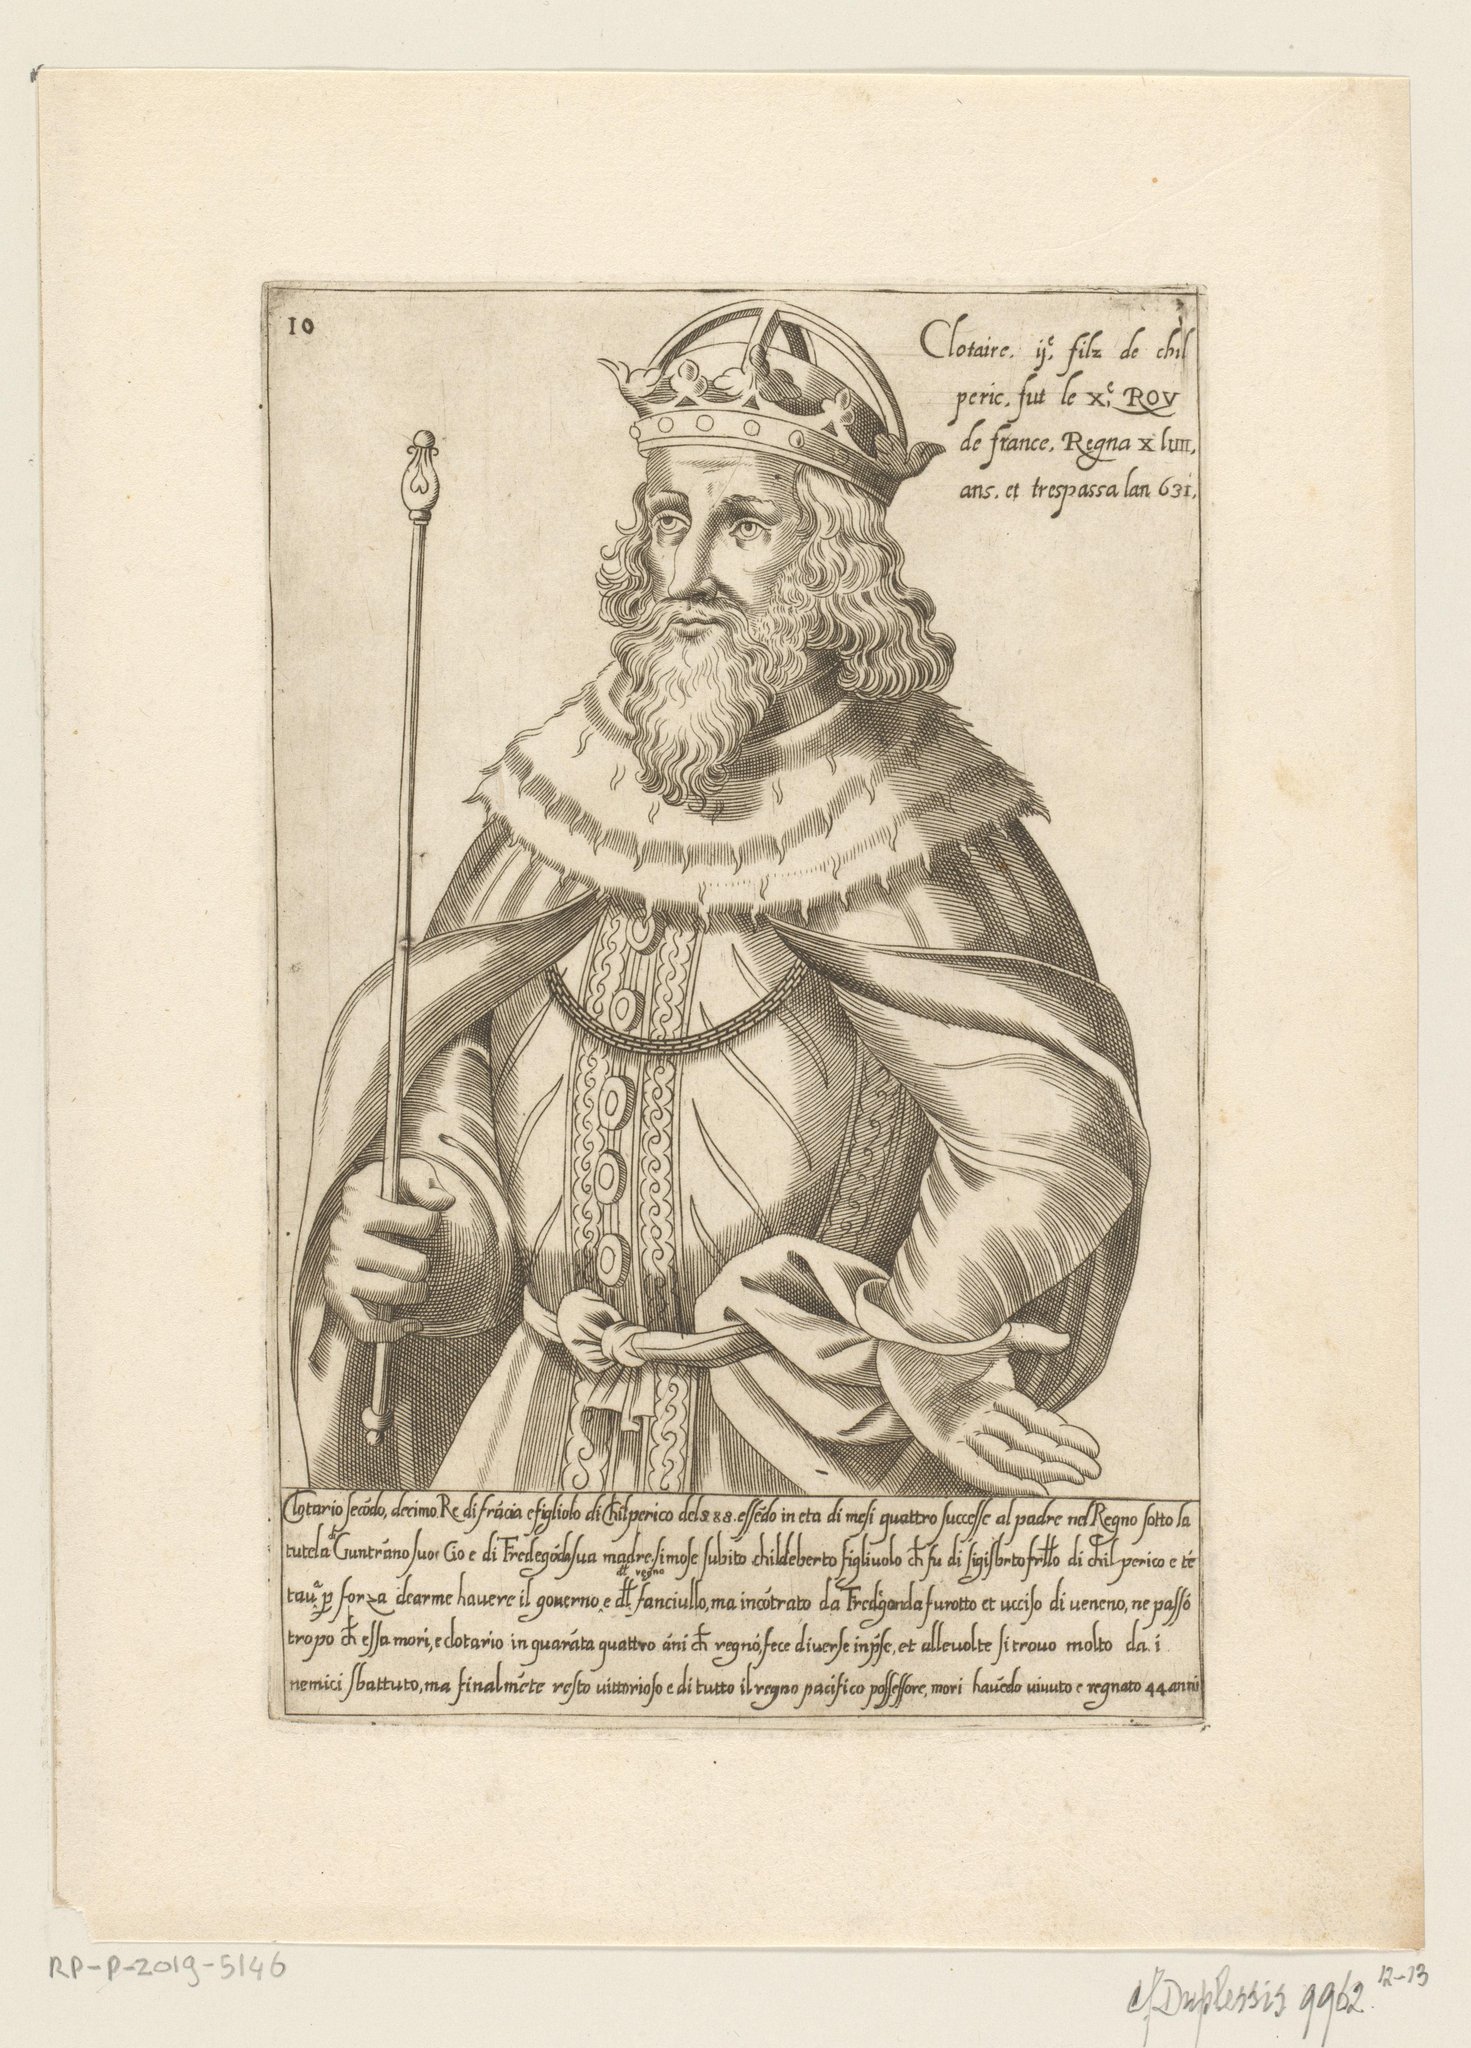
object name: print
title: Portret van Chlotharius II, koning der Franken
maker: Anonymous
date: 1588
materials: paper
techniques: engraving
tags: paris, crown (symbol of sovereignty), sceptre, staff (symbol of sovereignty), historical persons, king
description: Prent voor het eerst gebruikt in: Cronica Breve de i fatti illustri de're di Francia, con le loro effigie dal naturale cominciando da Faramondo (...). Venetië: Bernardo Giunti, 1588. Prent in ieder geval ook gebruikt in de editie van 1590 en mogelijk ook in een Franse uitgave van 1597.